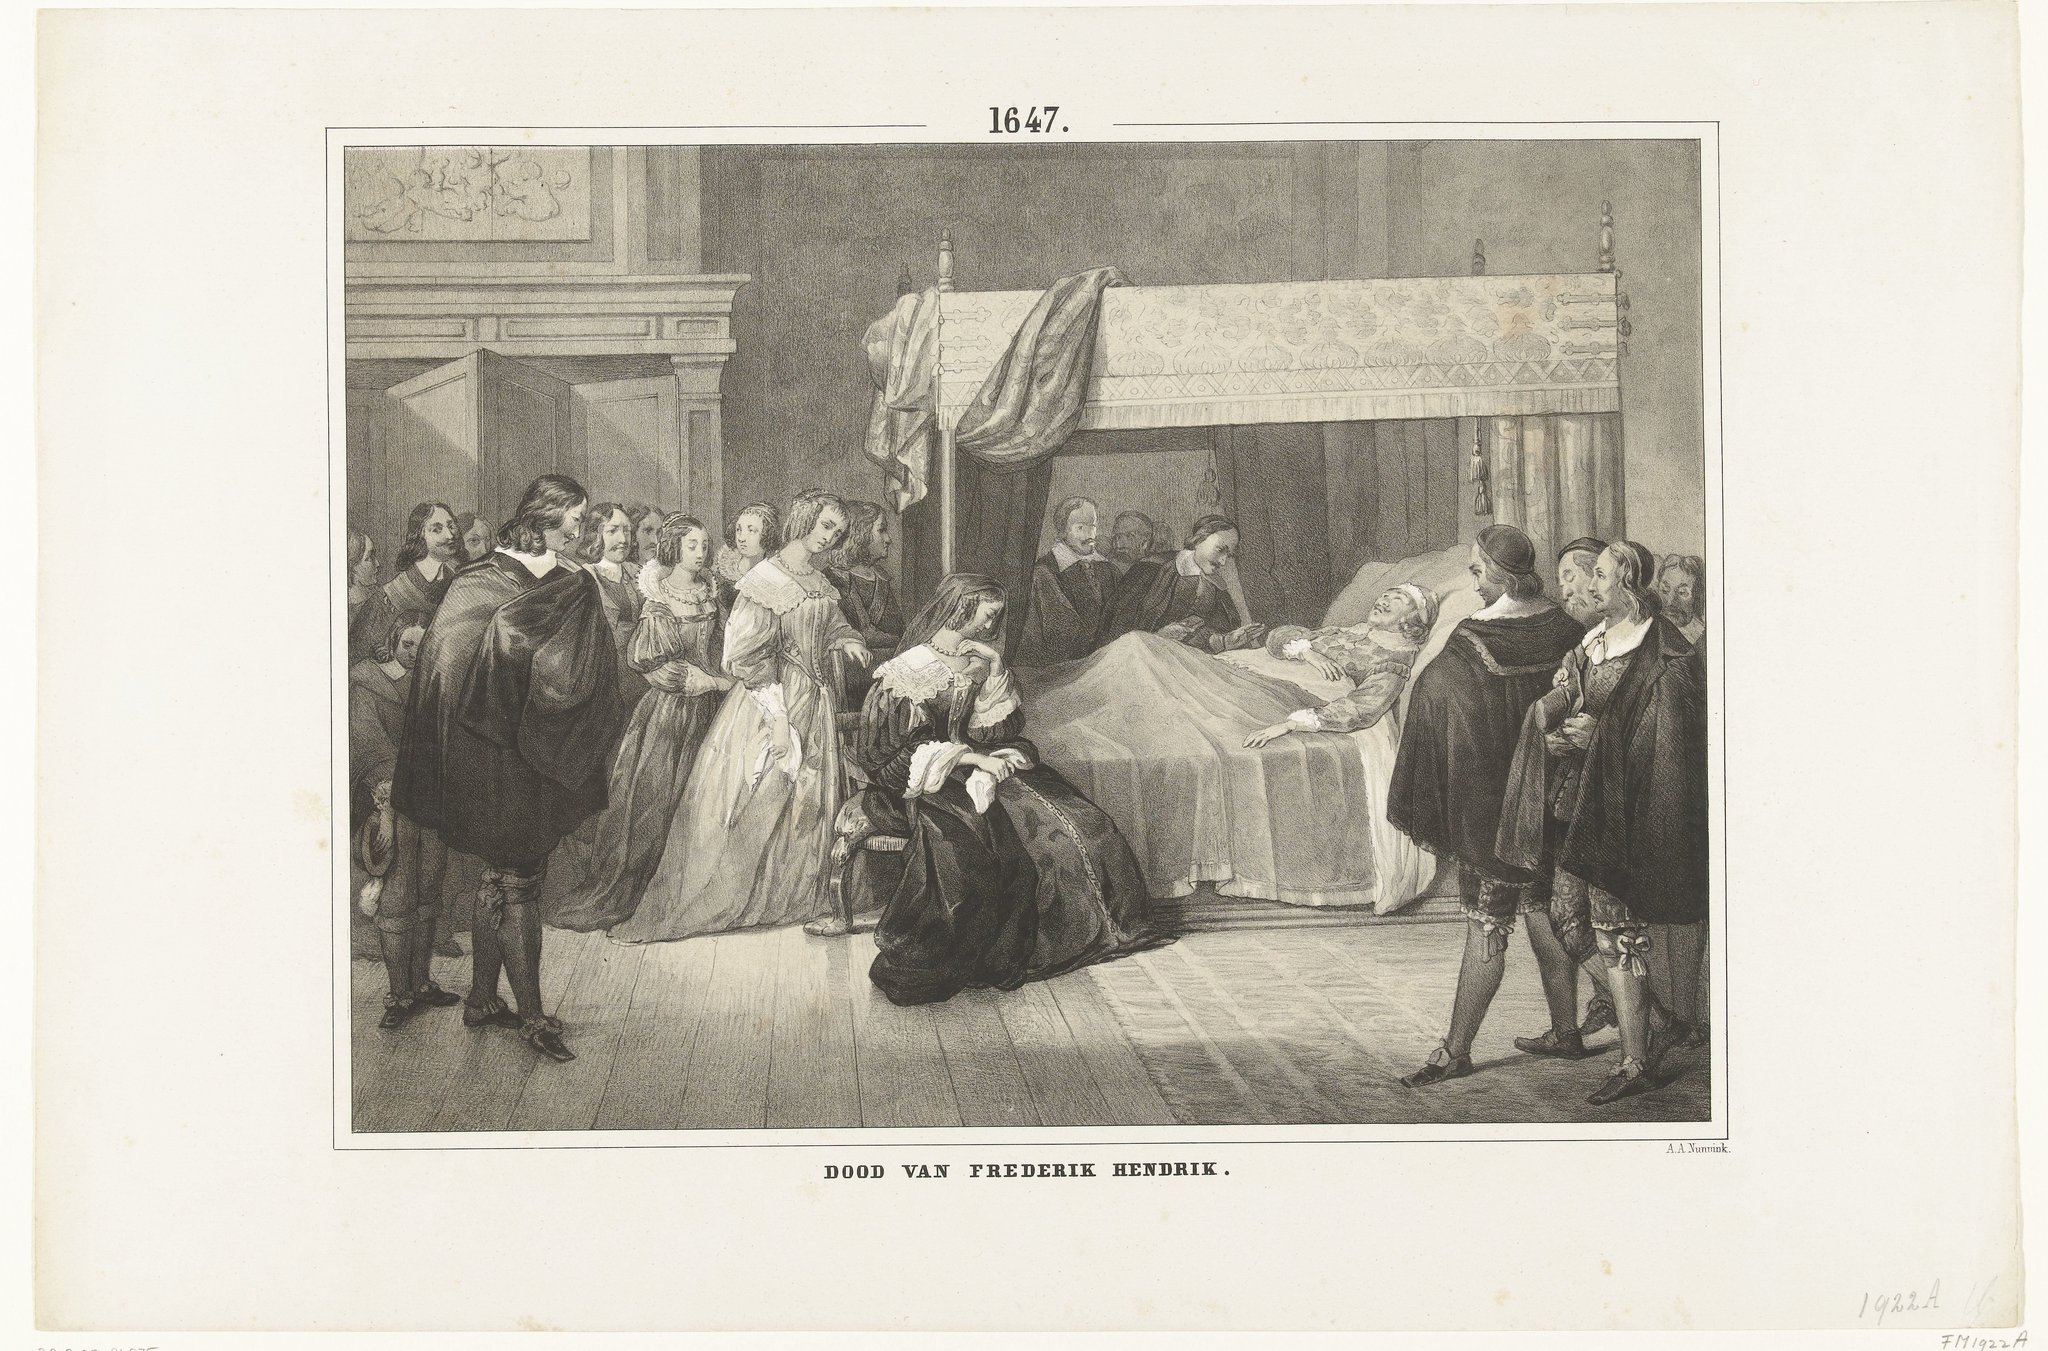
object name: history print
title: 1647 / Dood van Frederik Hendrik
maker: albertus anthonius nunnink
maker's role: print maker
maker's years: 1816-1895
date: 1853-1855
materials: paper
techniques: tone lithography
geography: netherlands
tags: the hague, frederick henry (prince of orange), amalia of solms-braunfels, delft, deathbed, the death of frederick henry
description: Illustratie voor: J.H. Eichman & H. Altmann, Vaderlandsche historieplaten voor scholen en huisgezinnen, Leiden, 1855. Gebaseerd op de originele prent van Cornelis van Dalen naar A.P. van de Venne (FMH 1922).. Dit nummer is een door het RPK toegevoegd nummer en staat niet in Frederik Muller, het werk waar de prent voor is gemaakt of uit afkomstig is, staat wel vermeld in Frederik Muller.